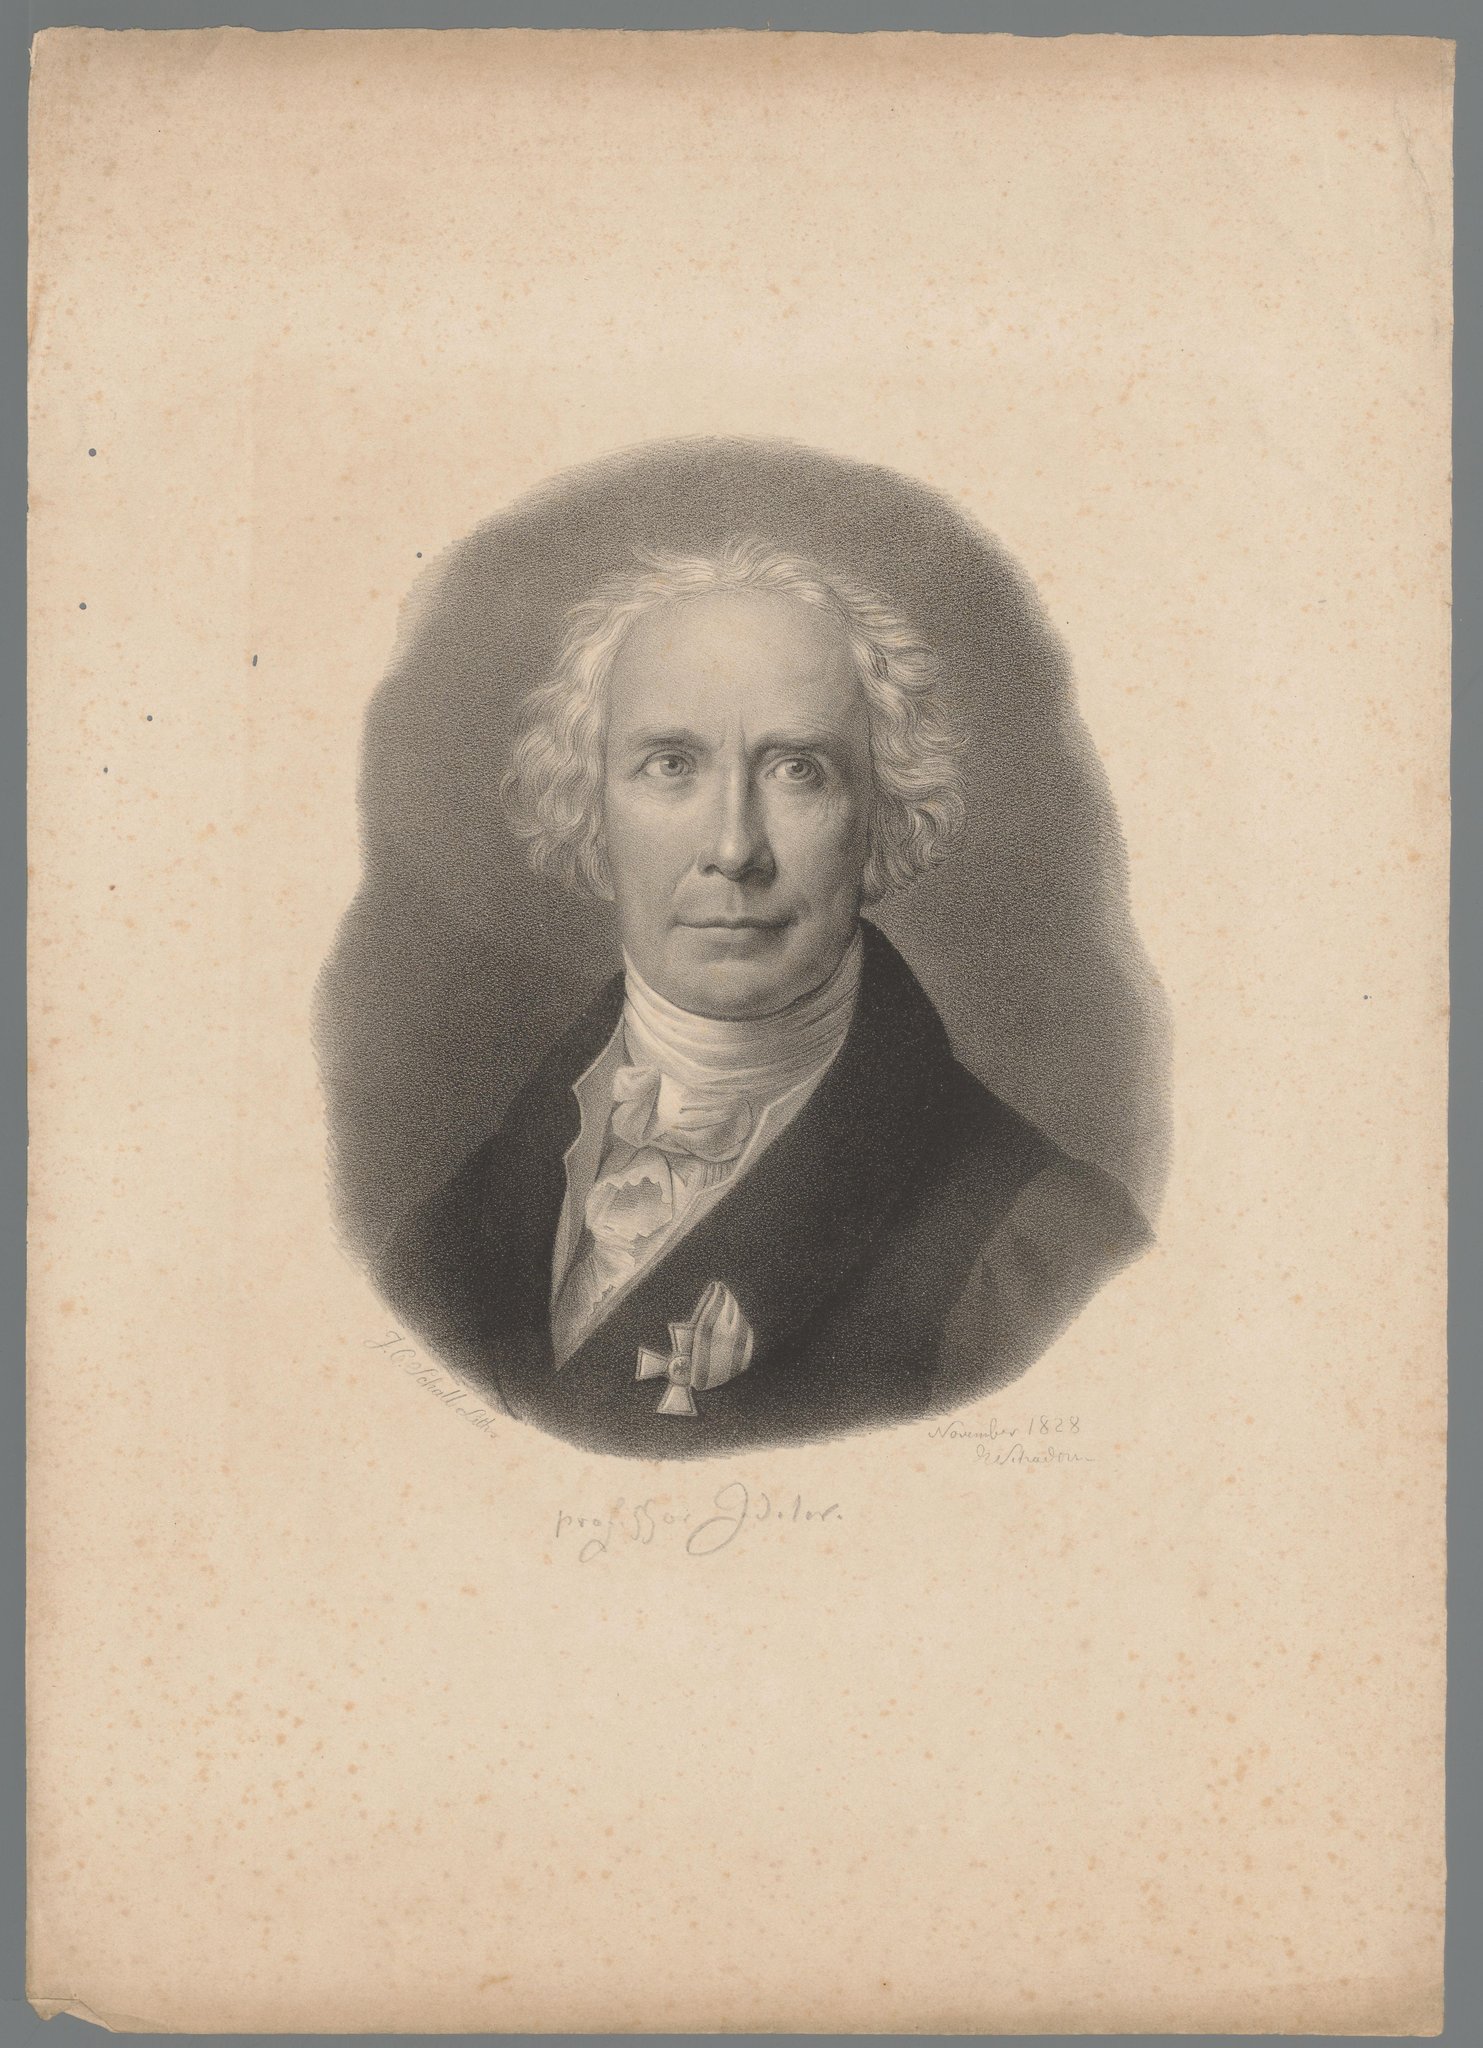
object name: print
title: Portret van een onbekende man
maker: j.c. schall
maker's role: print maker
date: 1820-1865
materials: paper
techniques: lithograph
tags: adult man, historical persons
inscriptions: collector's mark: Lugt 2228, inscription: ‘Professor [Iditer]’